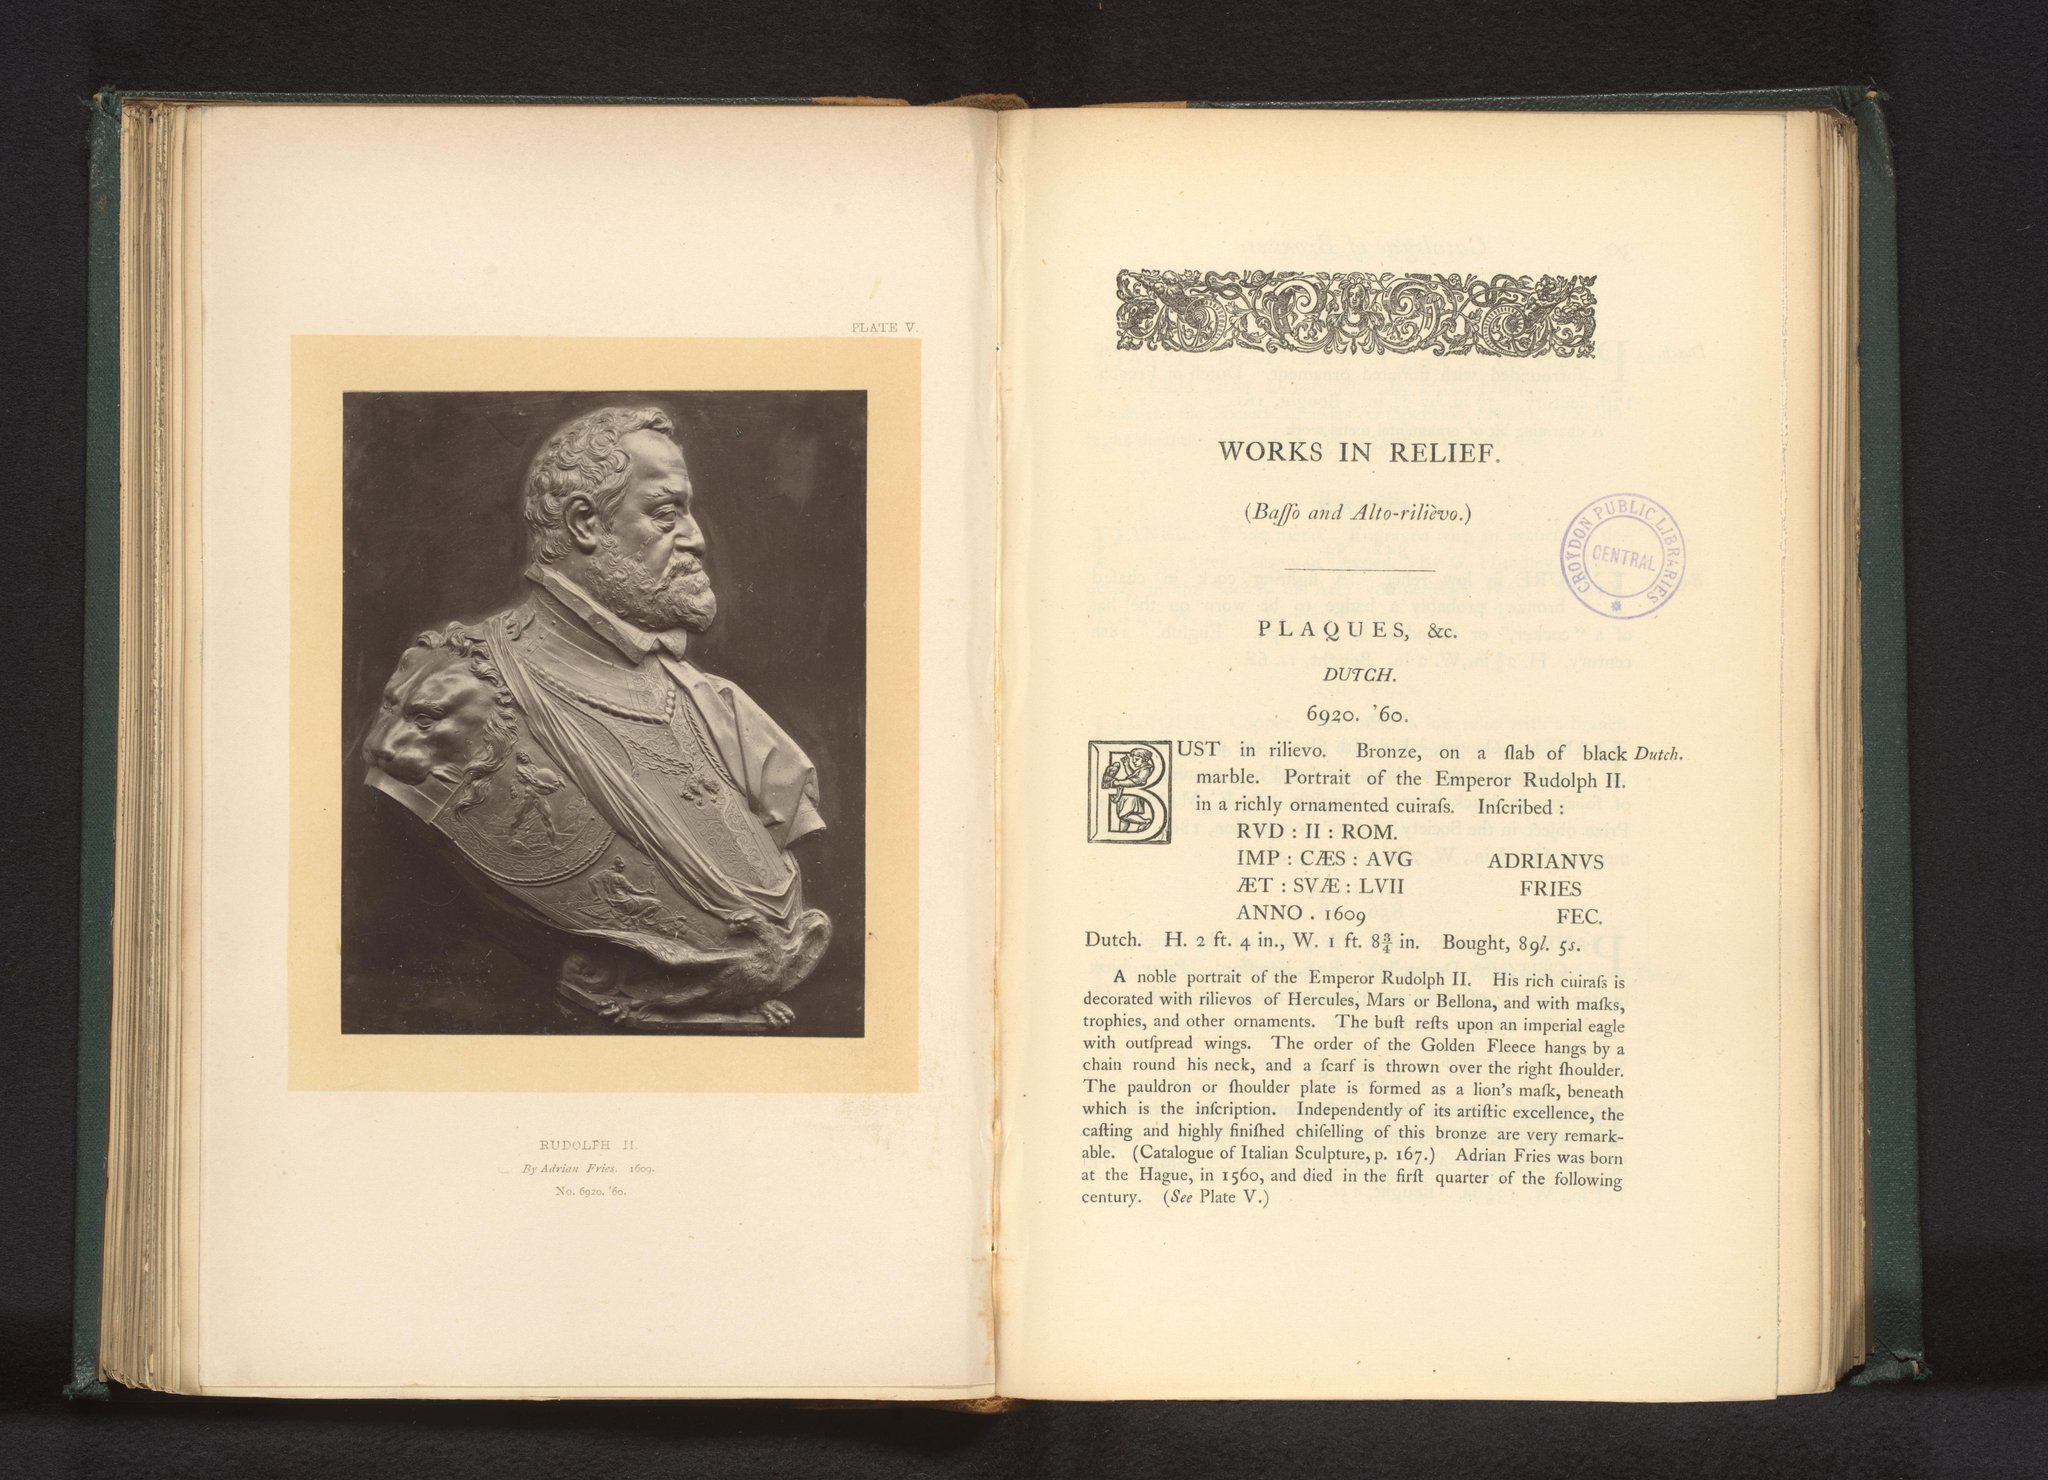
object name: page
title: Rudolph II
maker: Anonymous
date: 1869-1876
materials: paper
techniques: woodburytype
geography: london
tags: prague, rudolf ii van habsburg (duits keizer), ruler, sovereign, sculpture (+ relief ~ sculpture)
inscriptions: number: ‘No. 6920. '60.’, number: ‘Plate V.’, inscription: ‘By Adrian Fries. 1609.’